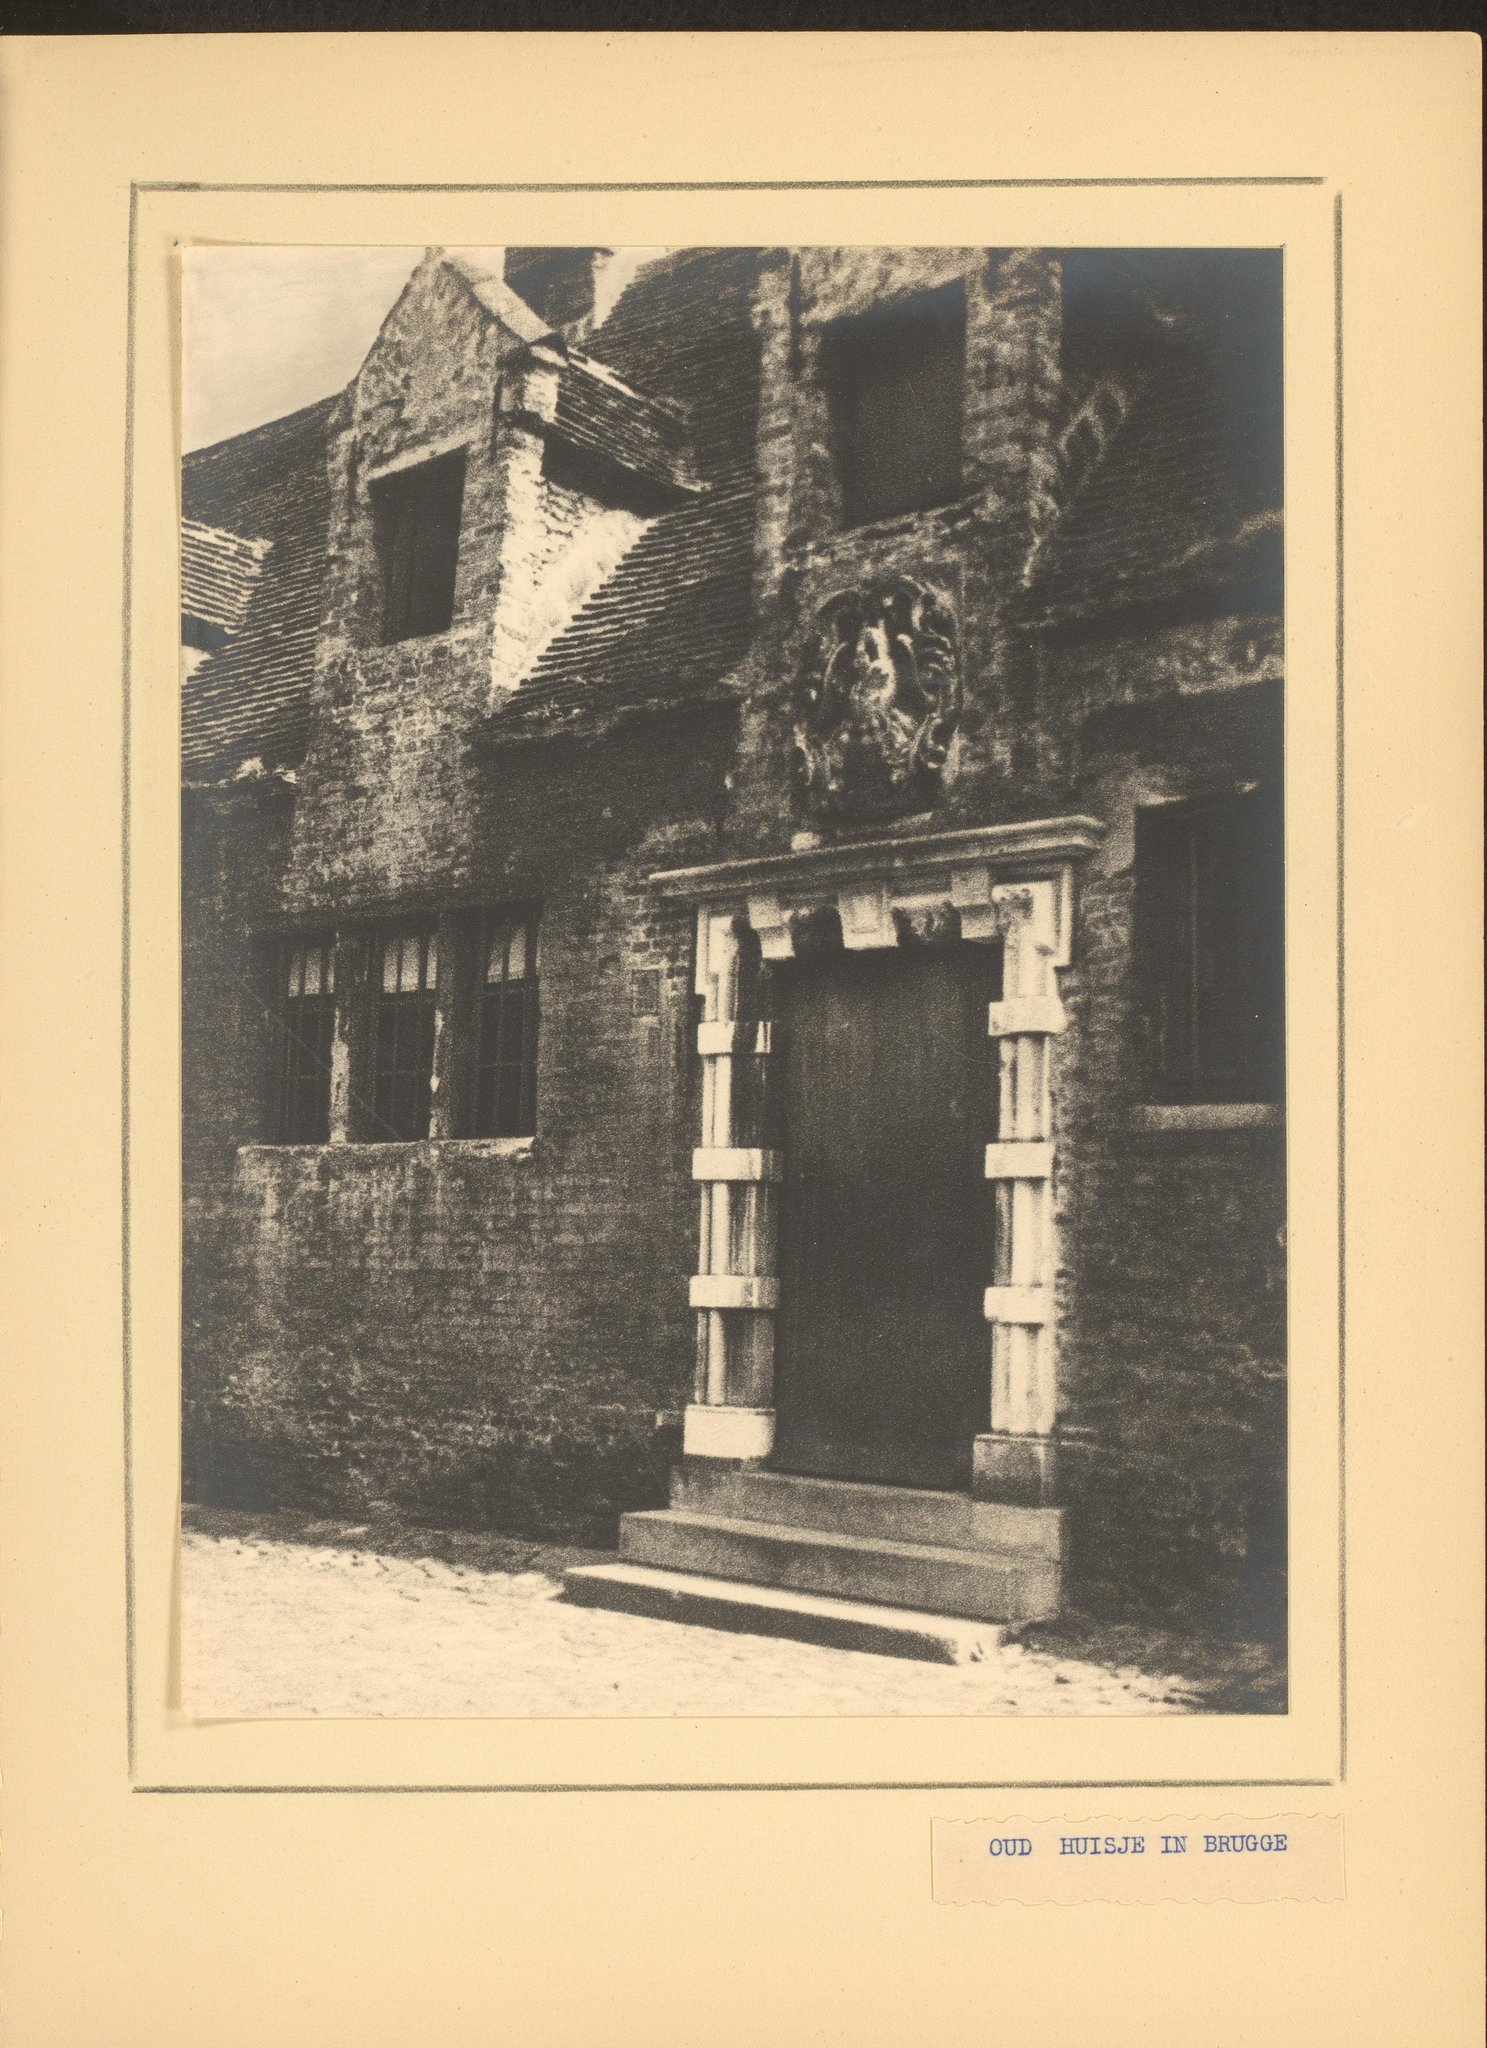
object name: photograph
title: Oud huisje in Brugge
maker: gerrit elink schuurman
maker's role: fotograaf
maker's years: 1876-1953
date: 1935-1937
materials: paper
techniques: gelatin silver print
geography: bruges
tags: urban housing, bruges